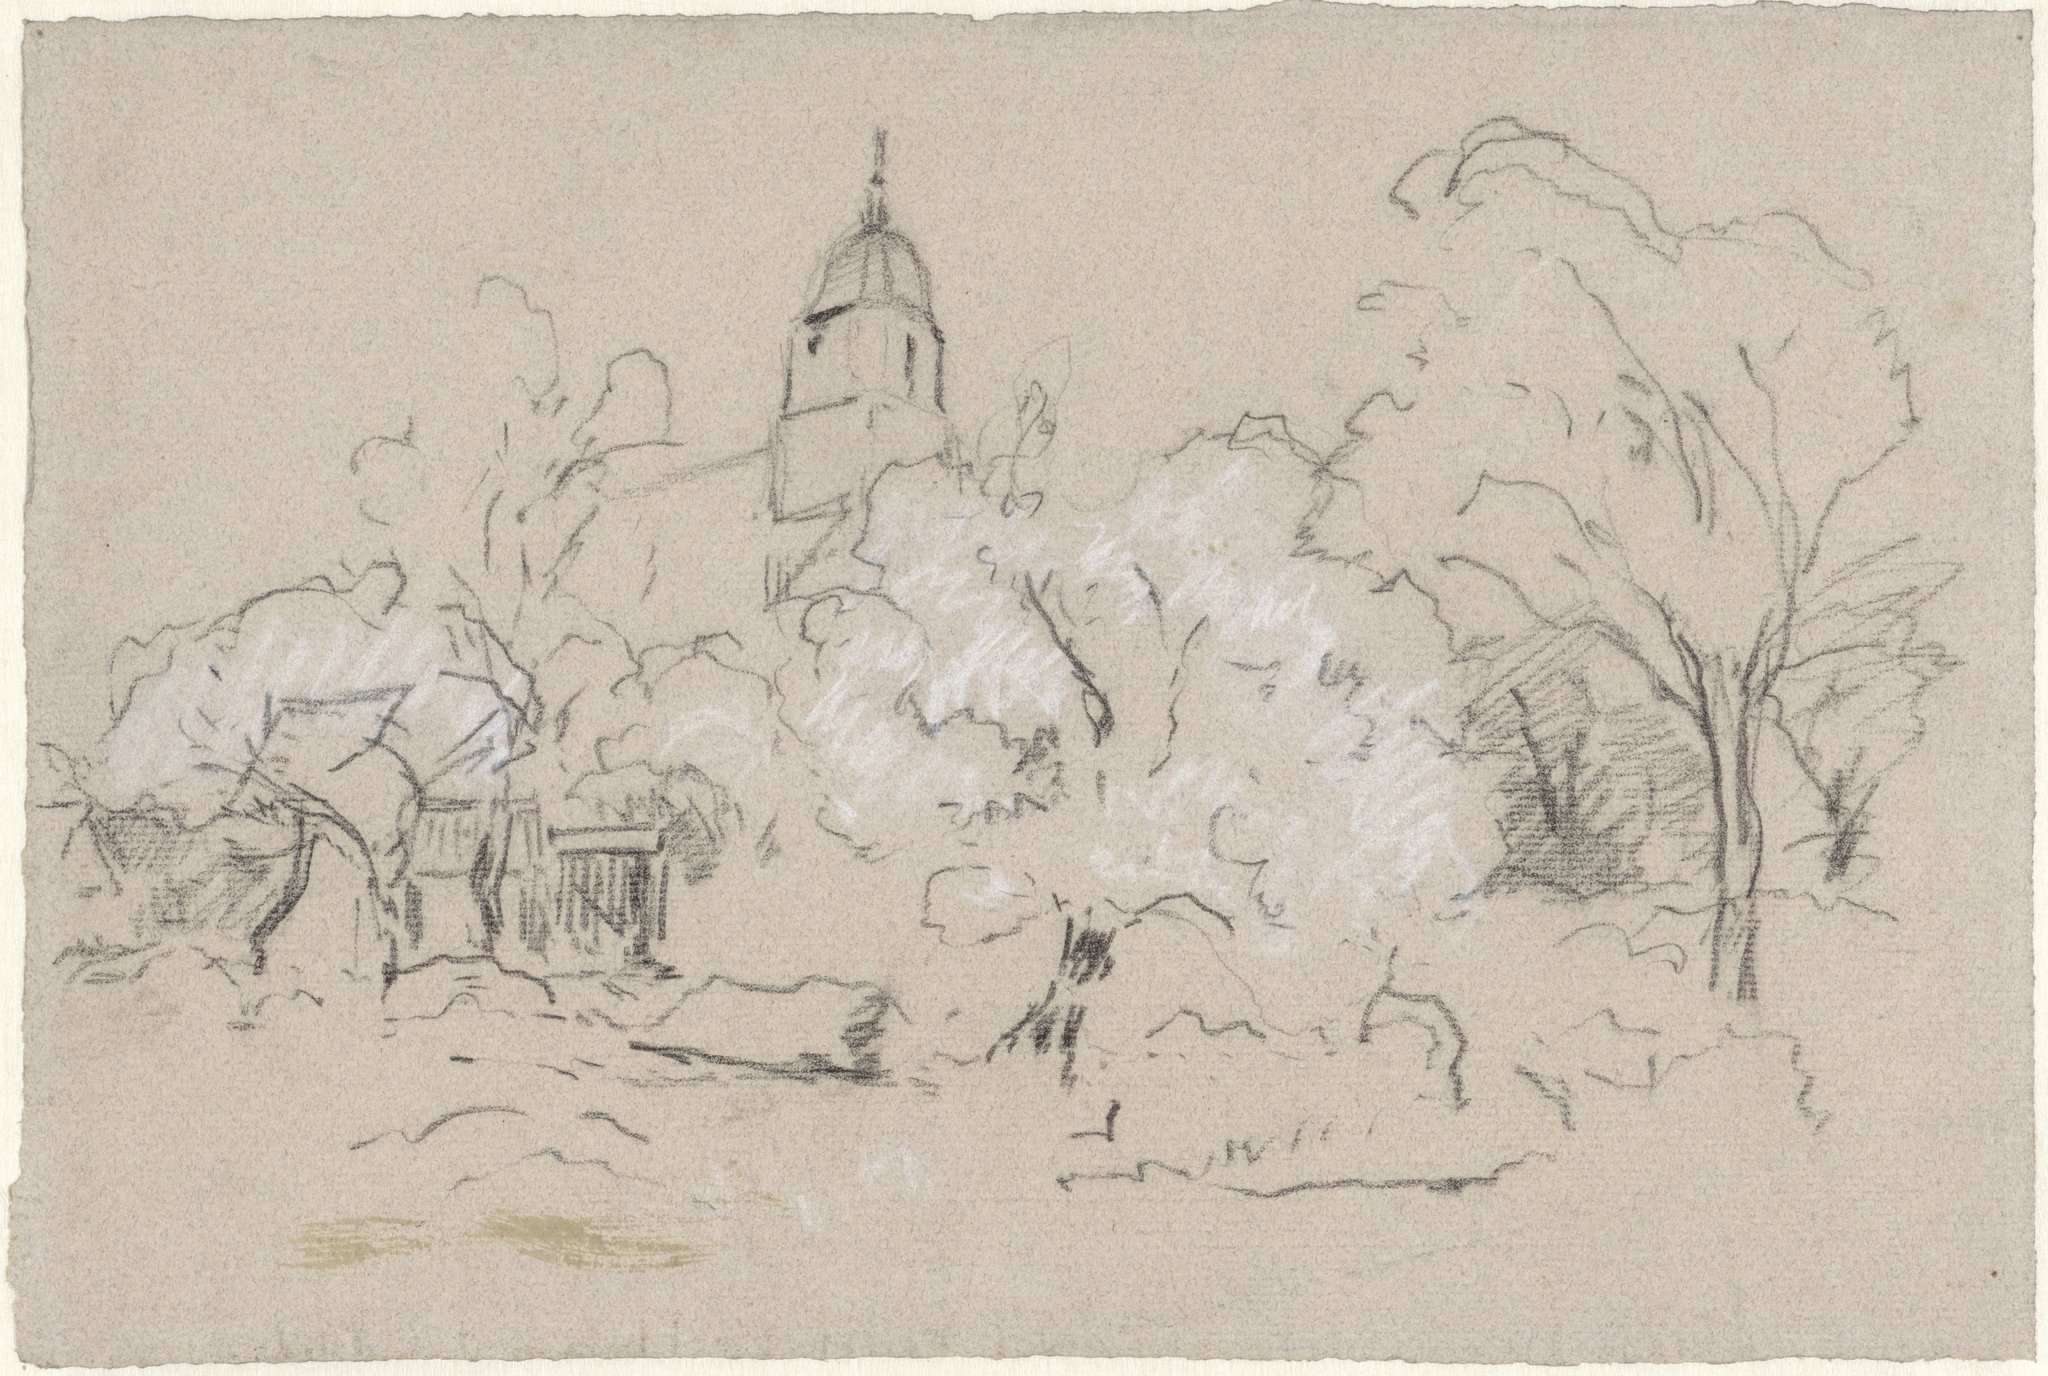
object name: drawing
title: Gezicht op een dorpje met kerk verscholen achter enkele bomen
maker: egbert rubertus derk schaap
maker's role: draughtsman, painter, print maker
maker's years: 1862-1939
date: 1872-1939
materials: chalk, paper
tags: village